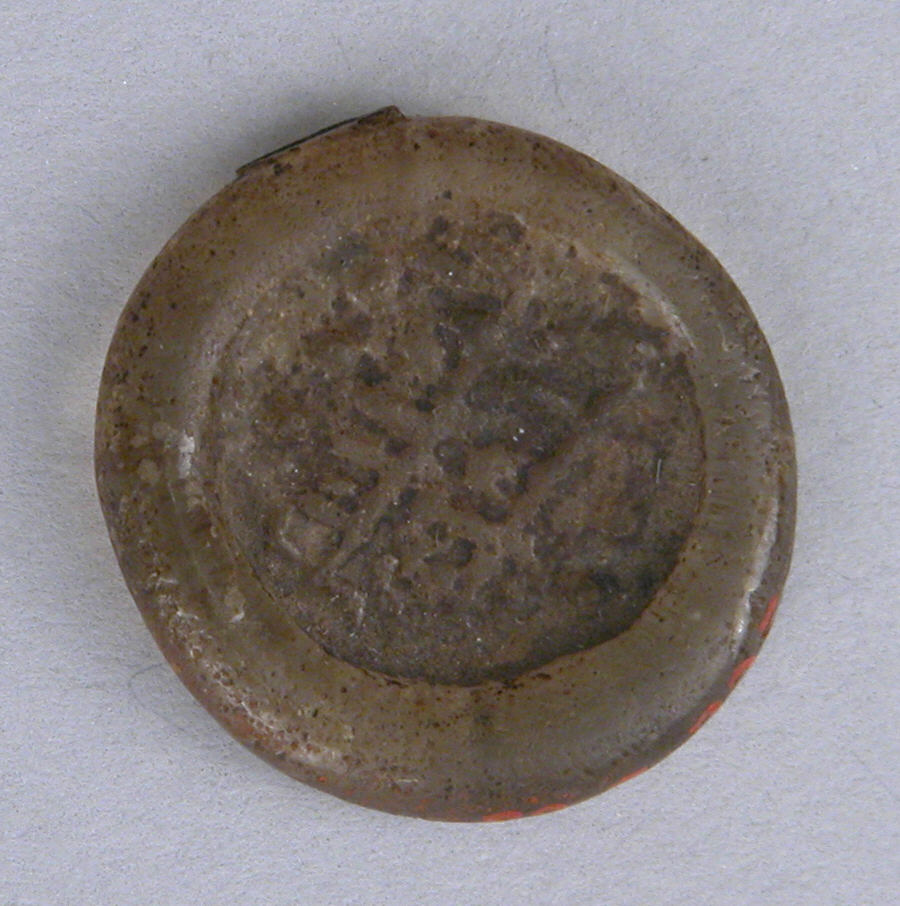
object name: coin weight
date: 901-1200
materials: glass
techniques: stamping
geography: egypt